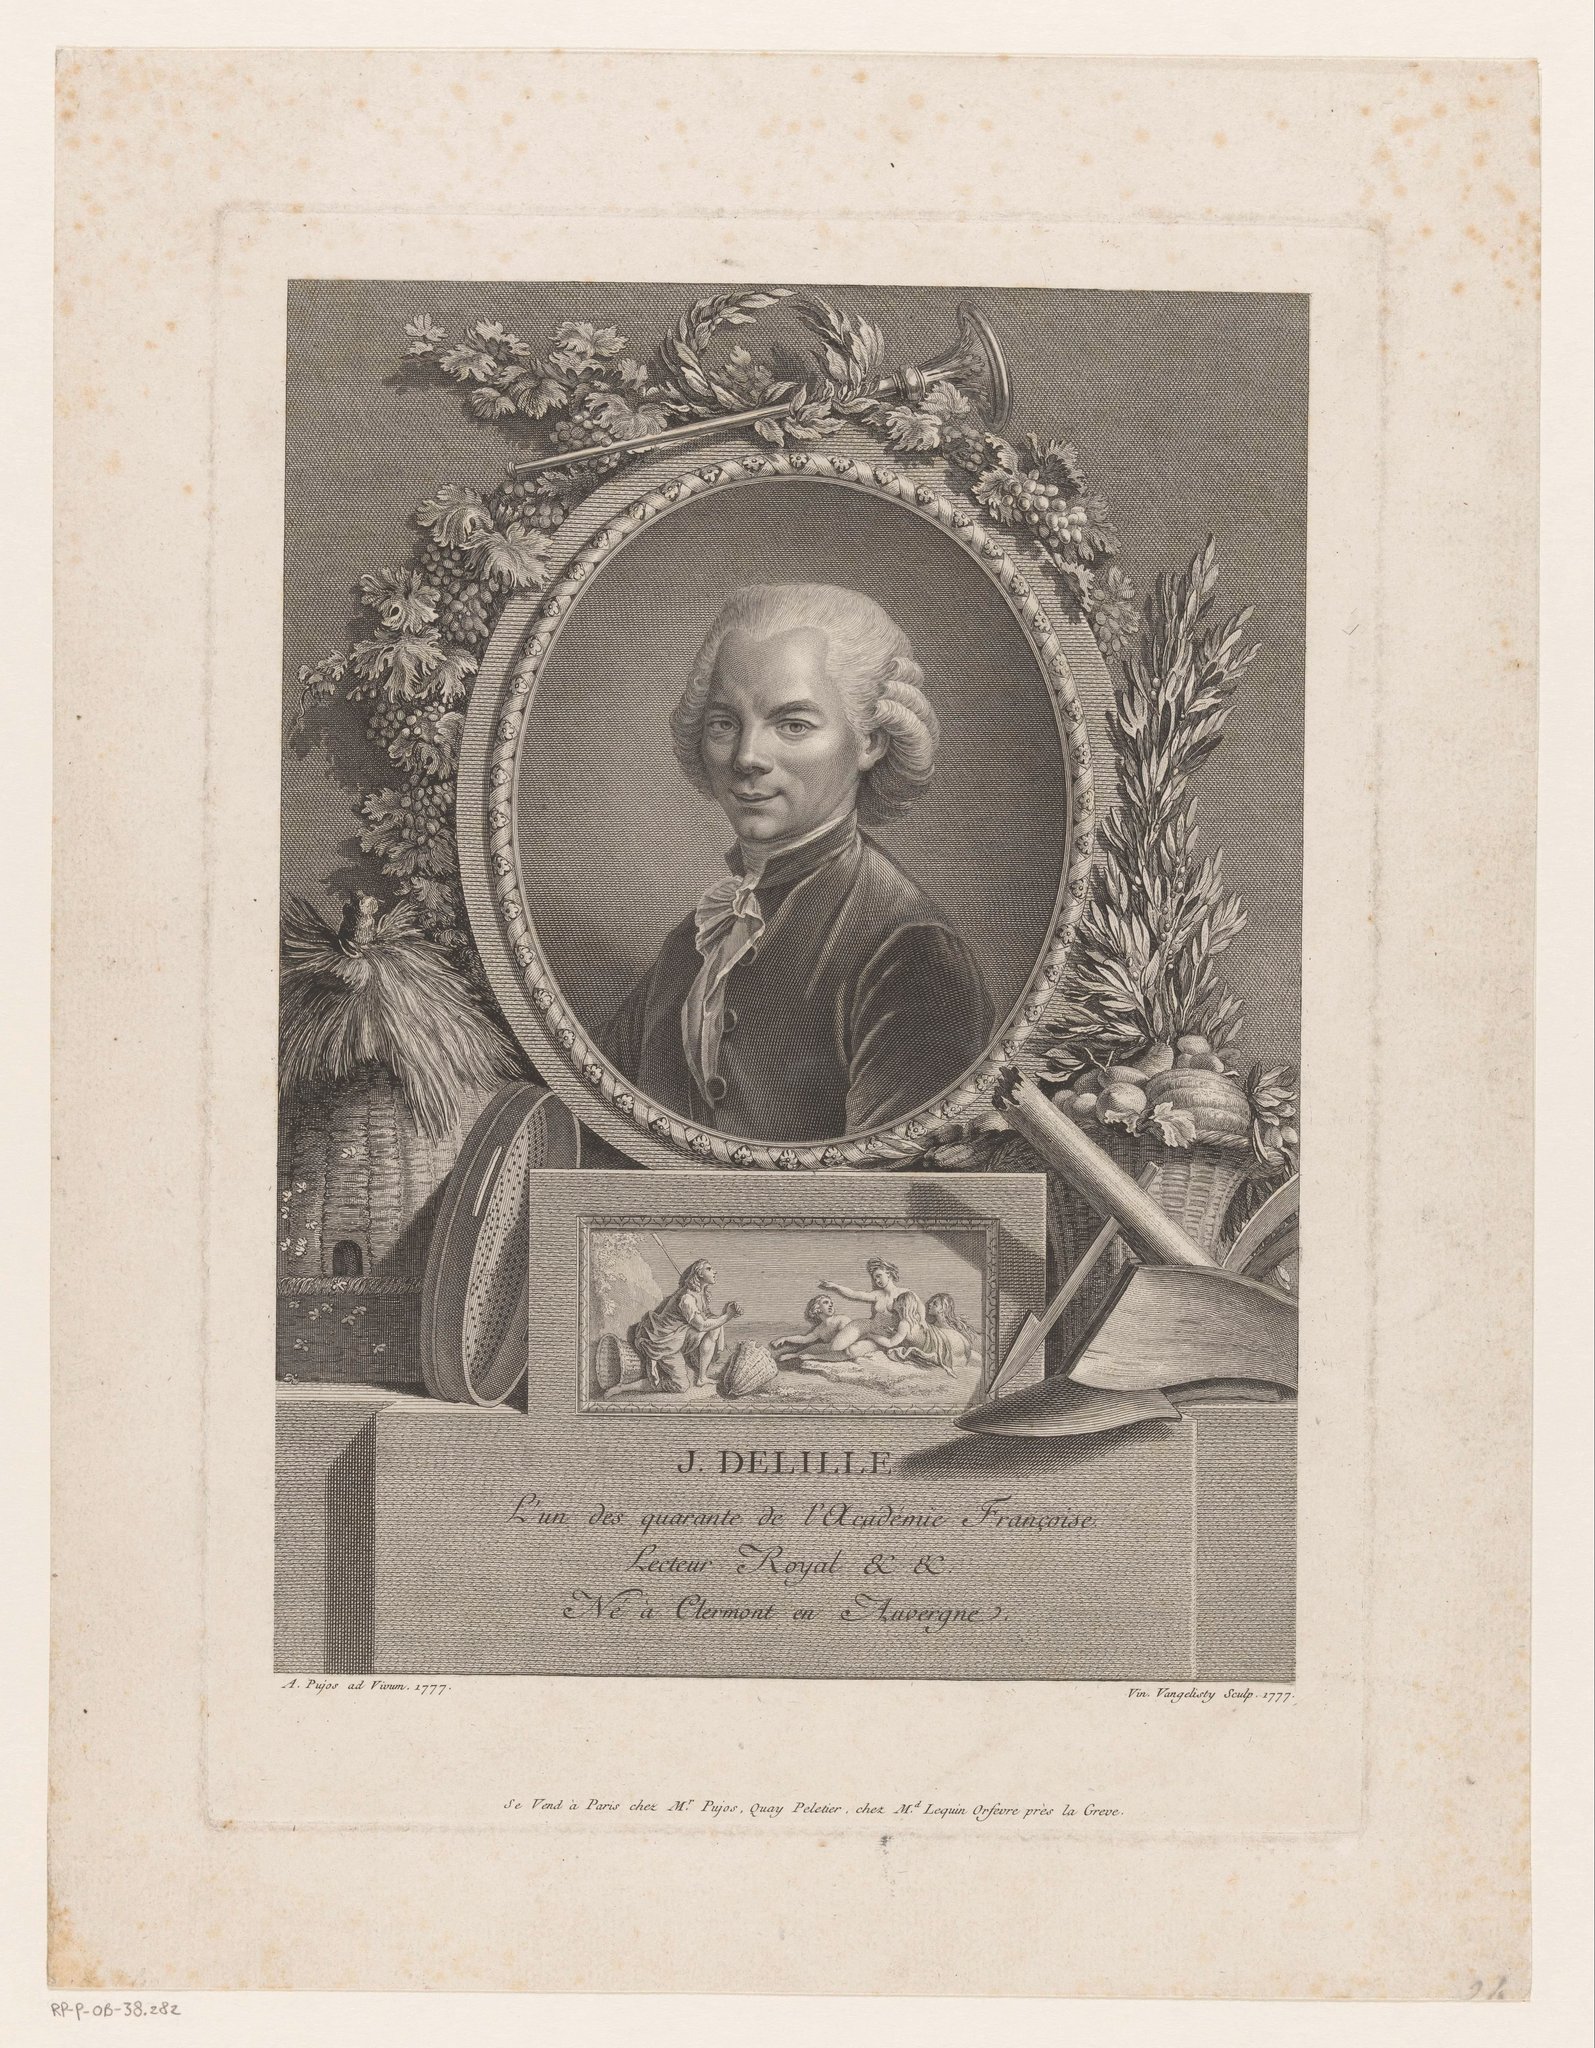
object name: print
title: Portret van dichter Jacques Delille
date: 1777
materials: paper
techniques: engraving, etching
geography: paris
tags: paris, jacques delille, historical persons, writer, poet, author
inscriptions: collector's mark: Lugt 240